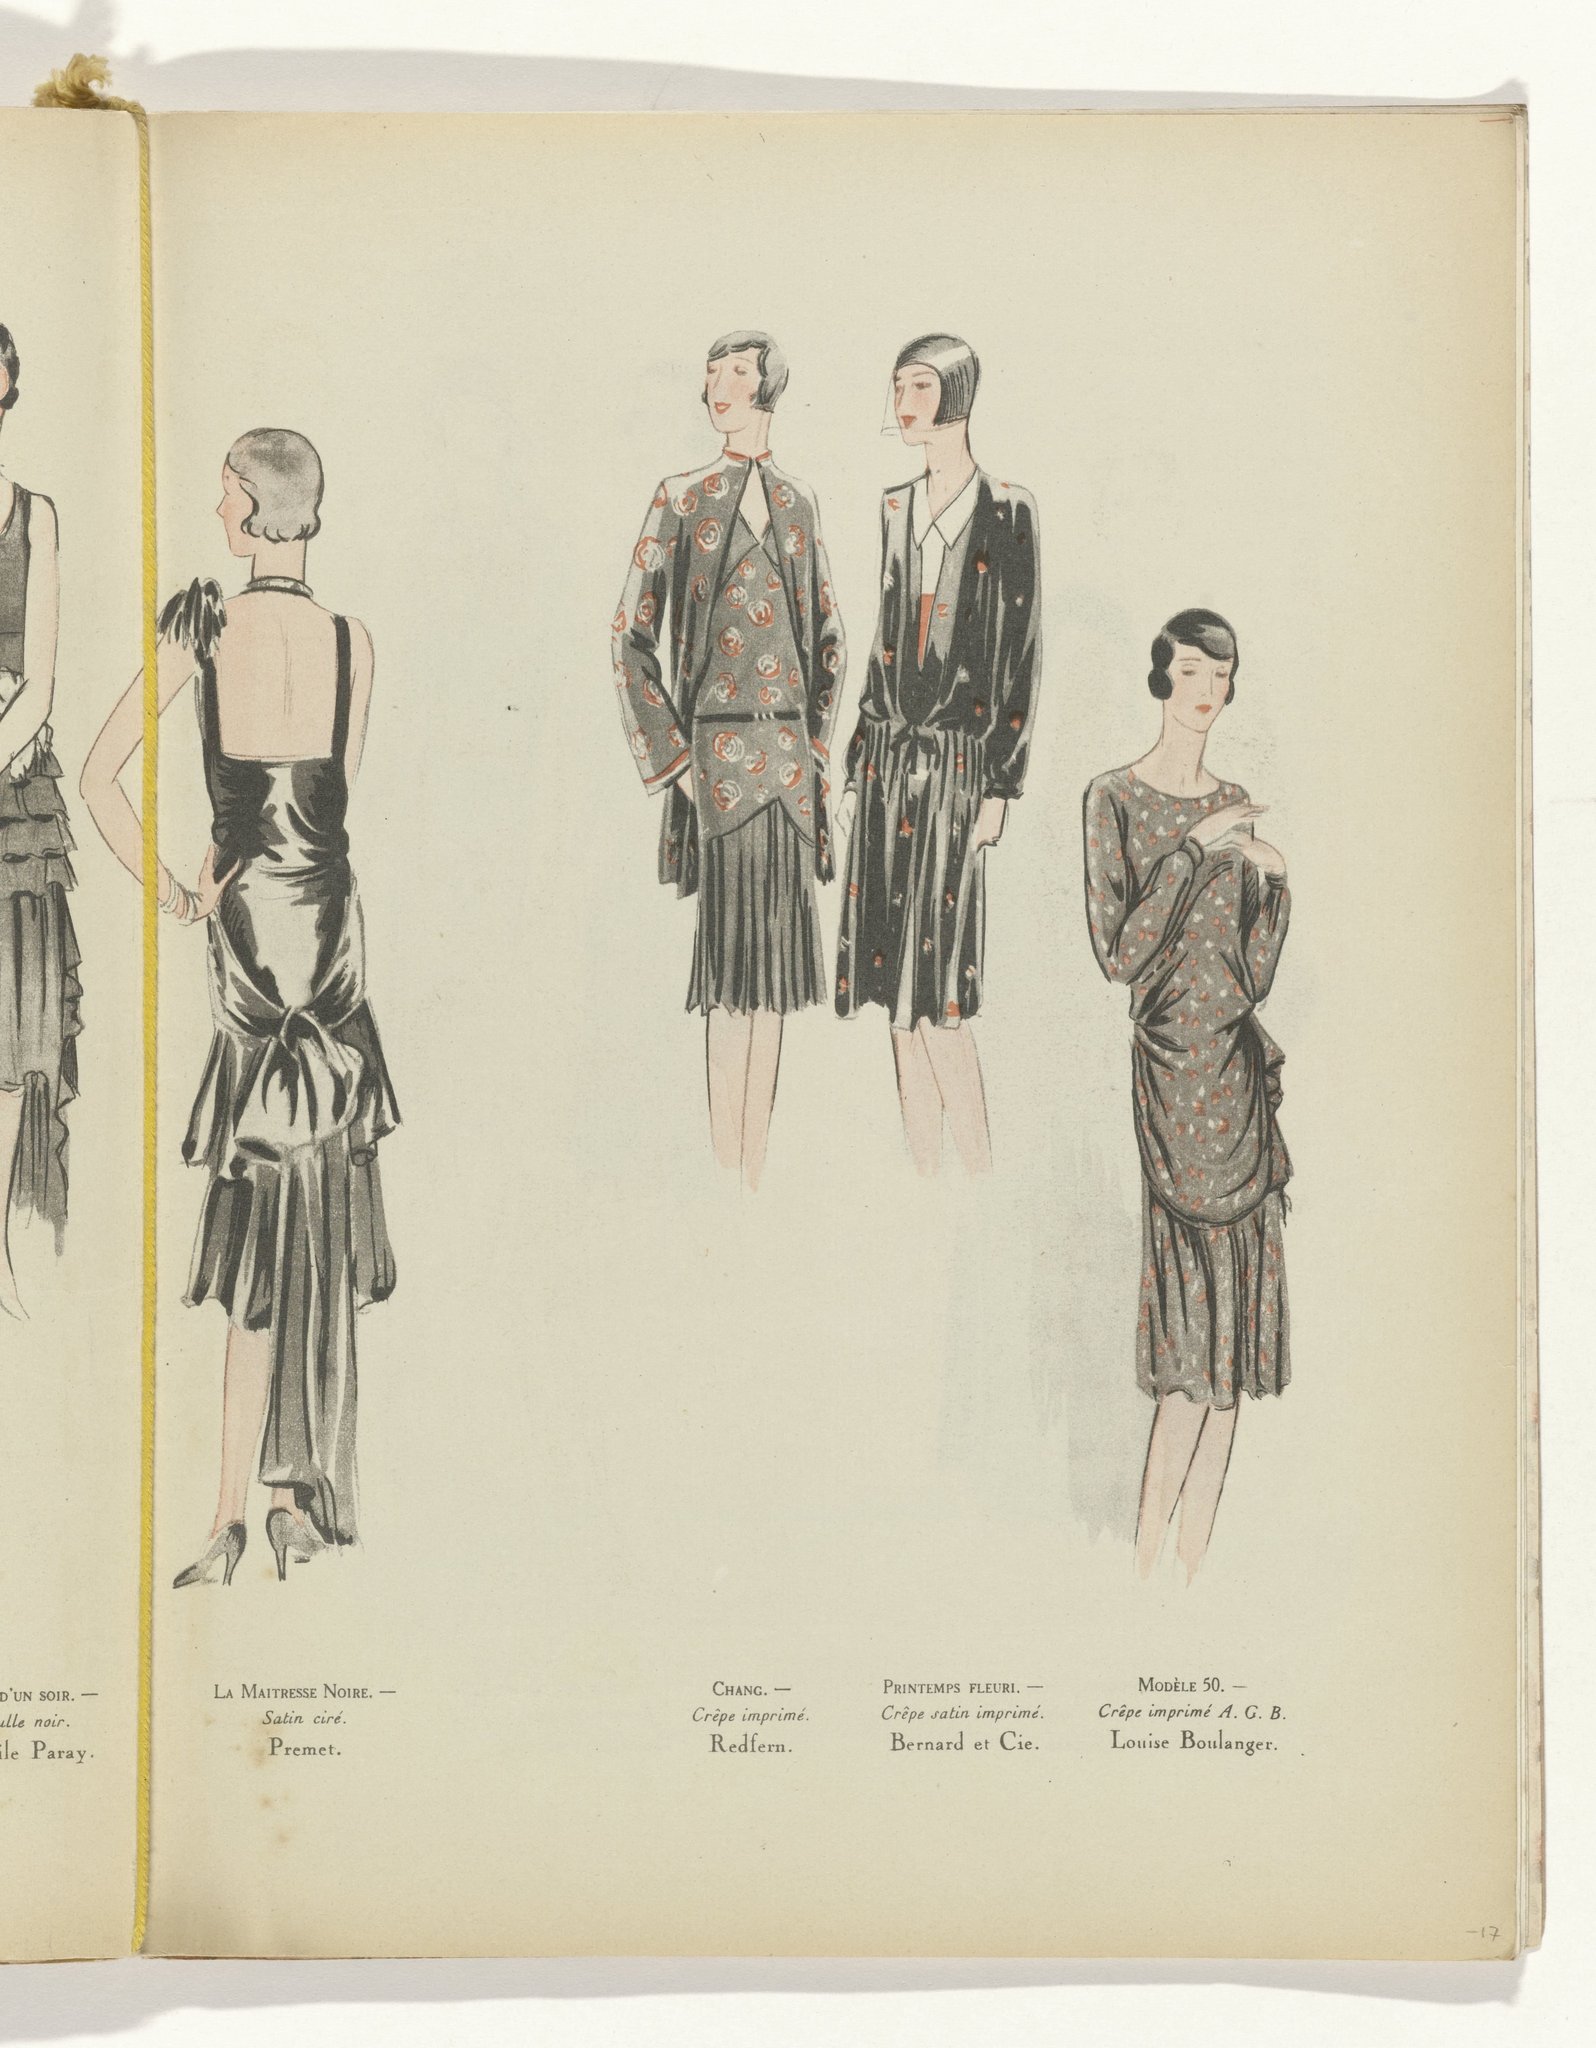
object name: magazine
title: Art - Goût - Beauté, Feuillets de l' élégance féminine, Mai 1929, No. 105, 9e Année, p. 18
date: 1929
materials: paper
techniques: printing, photography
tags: coat (+ women's clothes), fashion plates, dress, gown (+ women's clothes)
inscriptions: caption: ‘QUELQUES FLEURS. - Crêpe imprimé. Agnès. / BERENICE. - Ensemble lainage. Doeuillet - Doucet’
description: Japonnen van verschillende modehuizen. Van links naar rechts: Premet, Redfern, Bernard et Cie, Louise Boulanger. Pagina uit het modetijdschrift Art-Goût-Beauté (1920-1933).